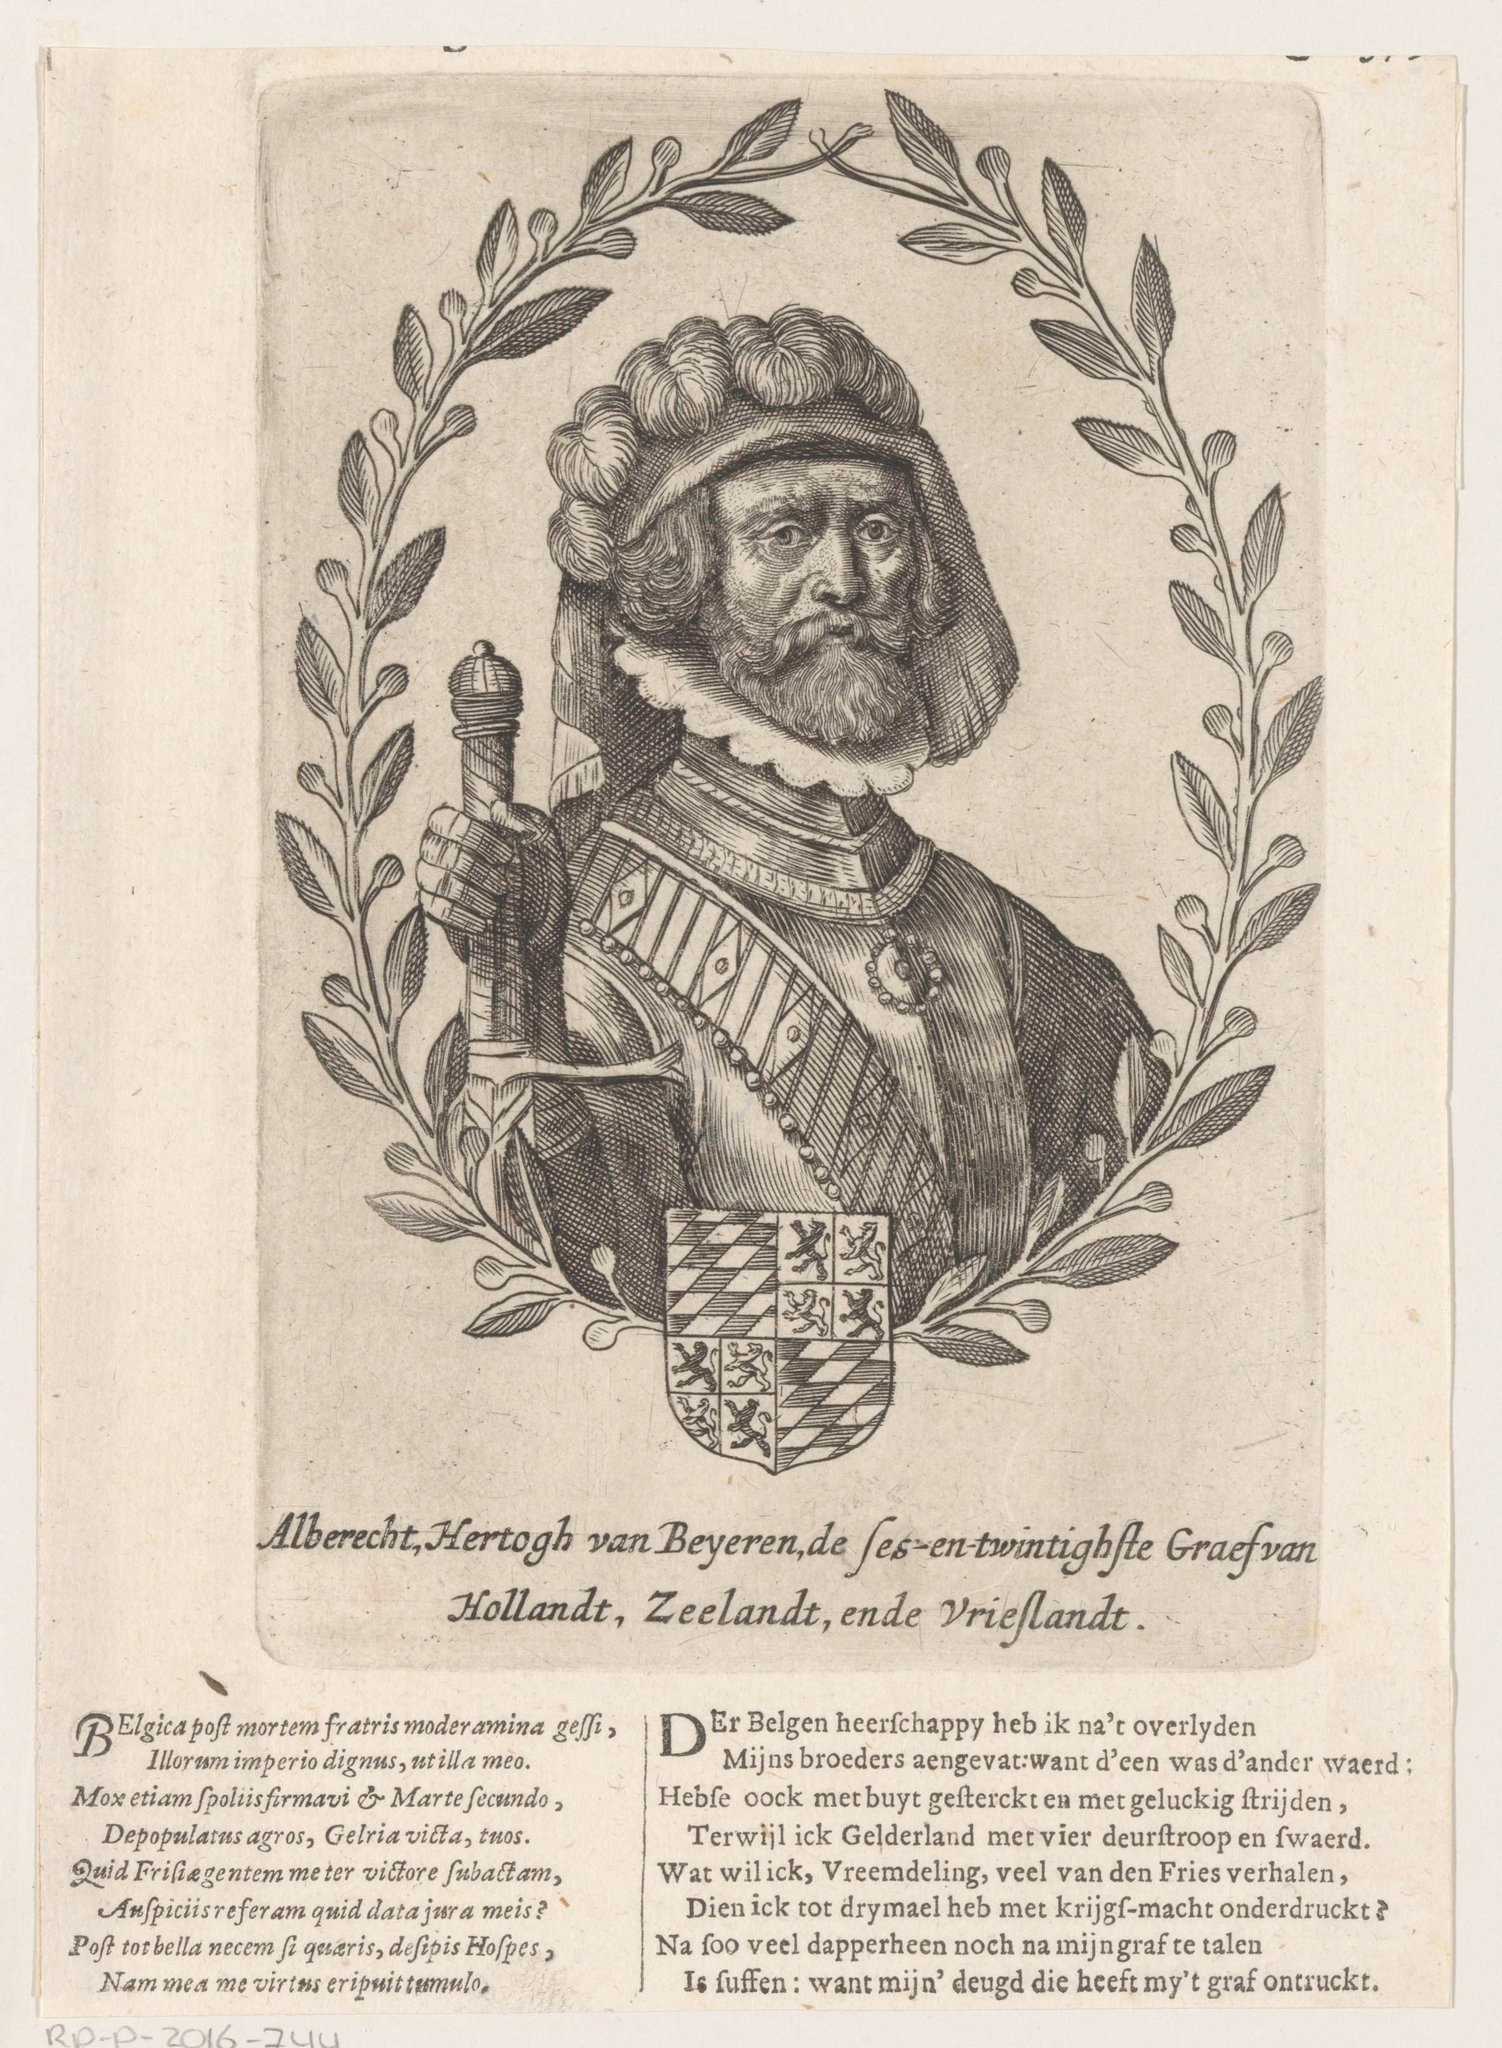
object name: book illustration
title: Portret van Albrecht van Beieren, graaf van Holland, Henegouwen en Zeeland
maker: Anonymous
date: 1600-1699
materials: paper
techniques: engraving, letterpress printing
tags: duke of bavaria albert i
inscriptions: collector's mark: Lugt 964